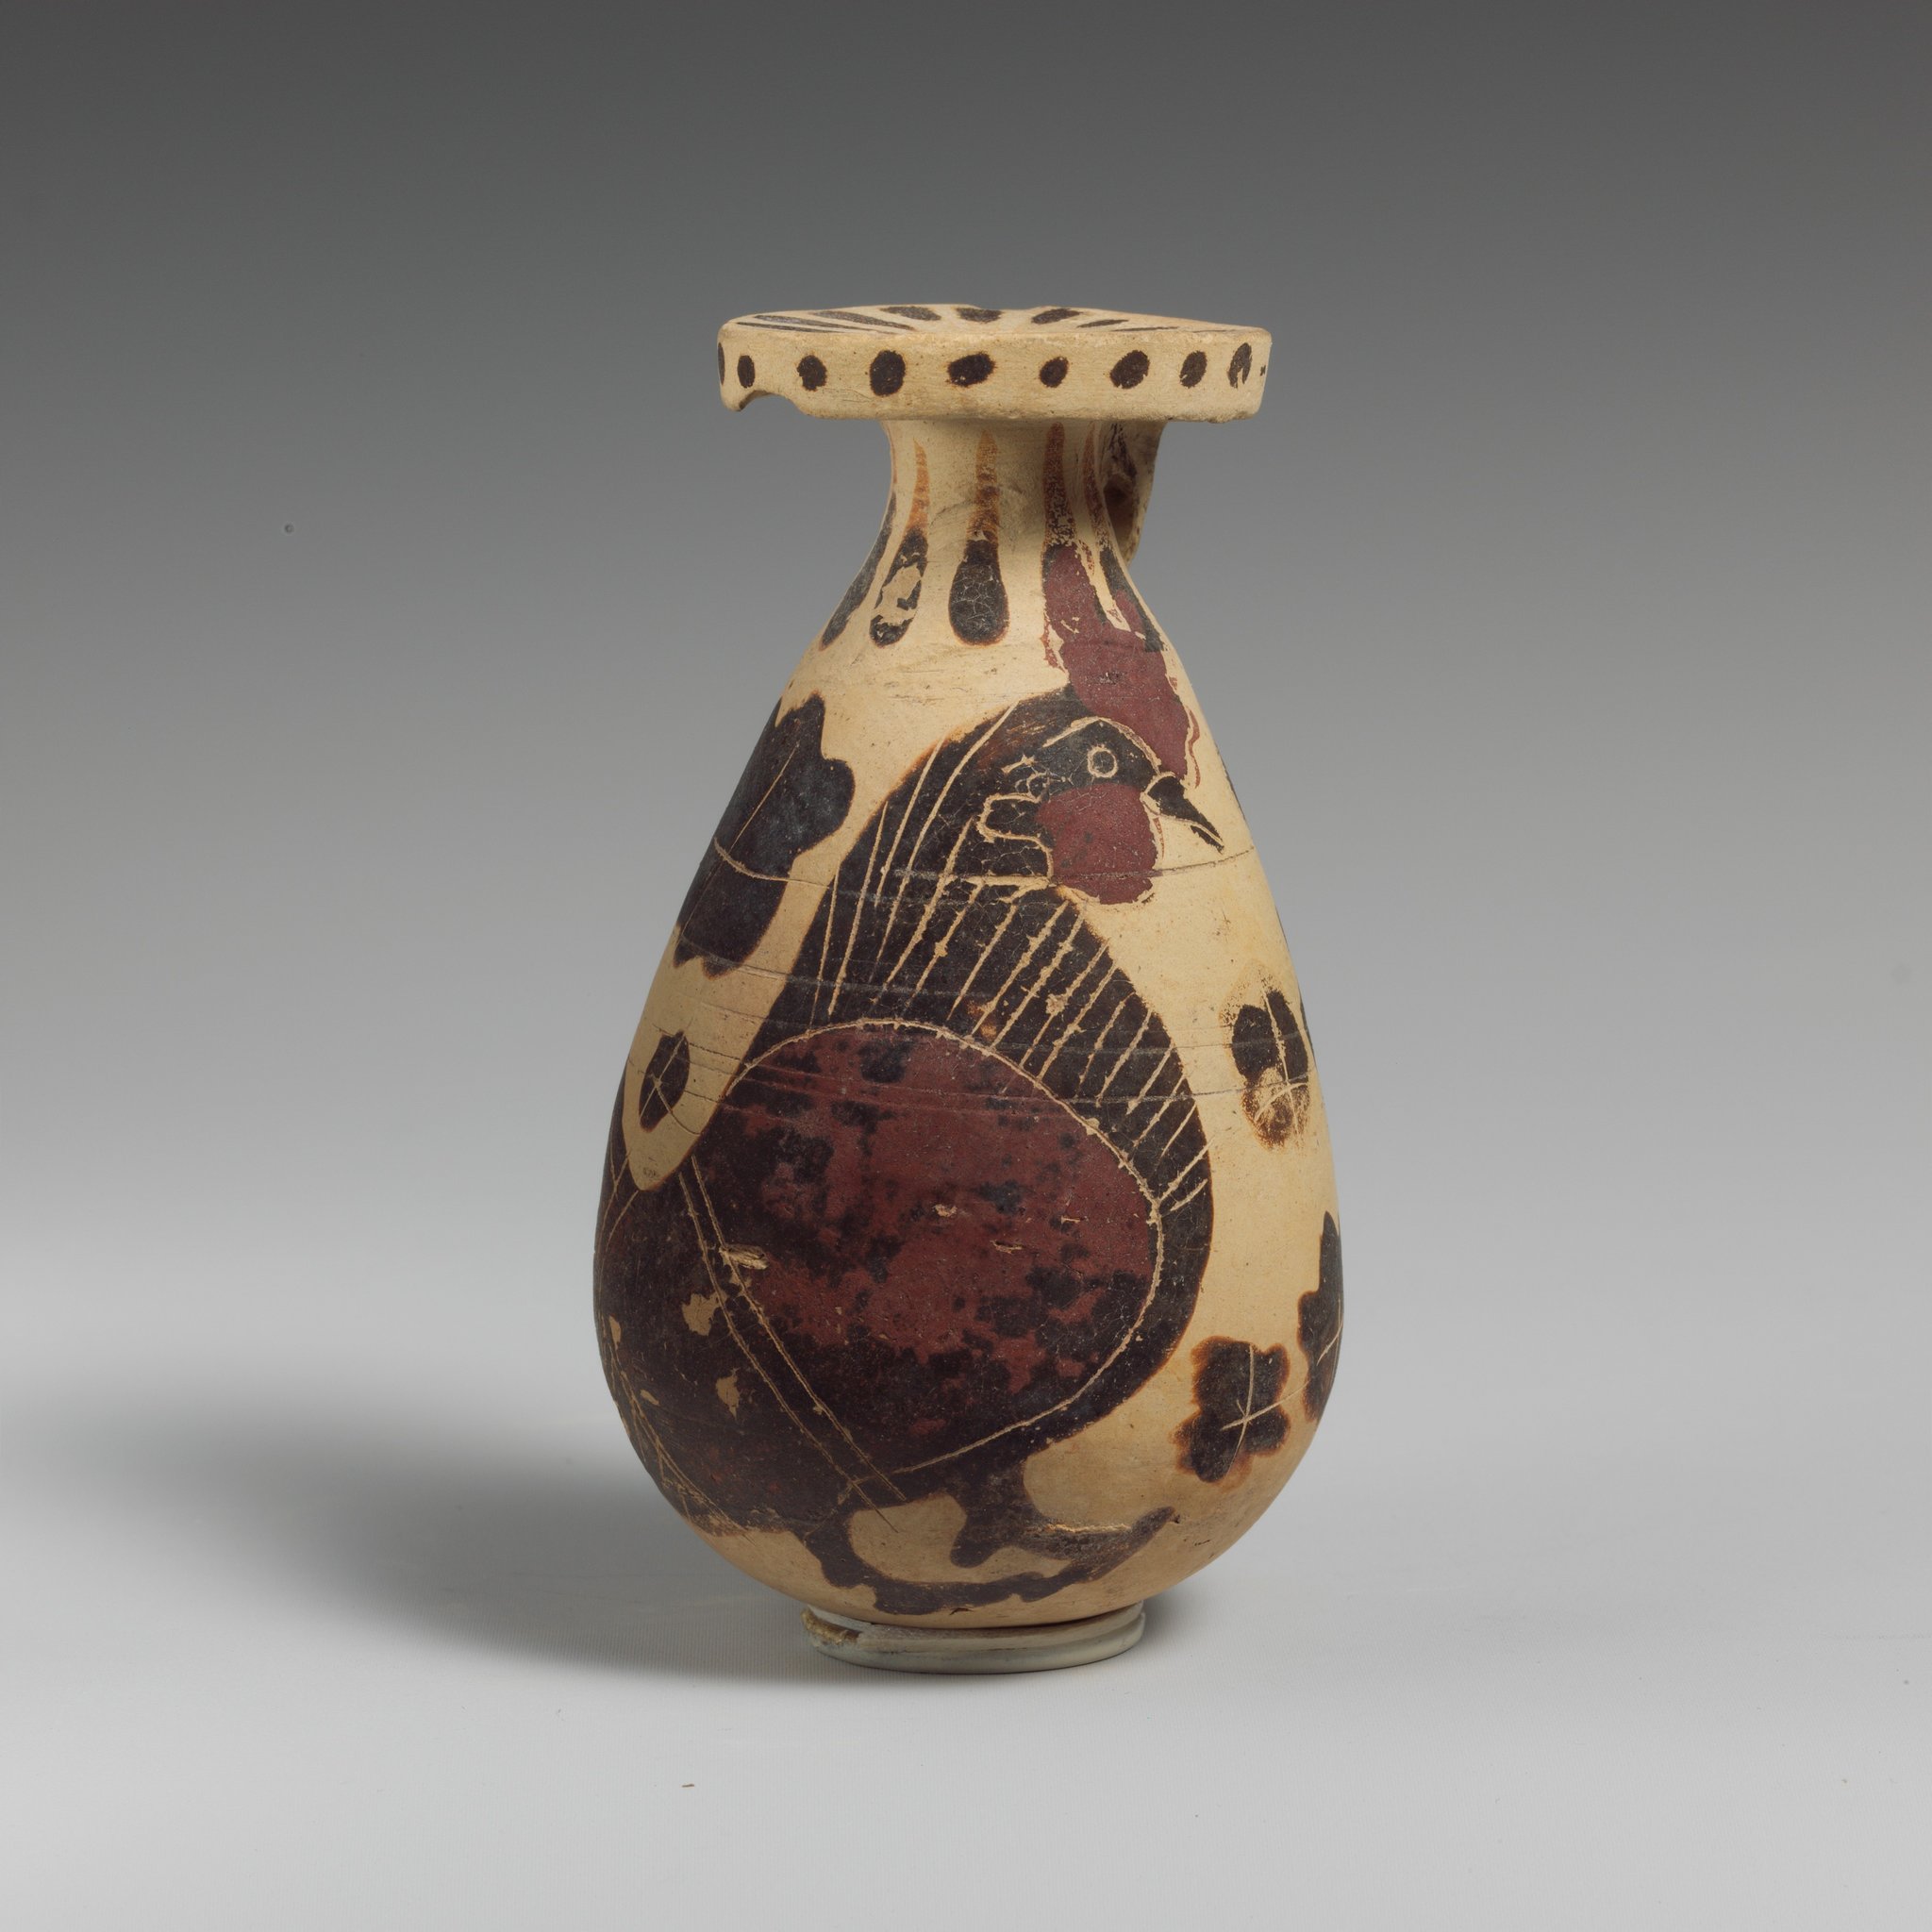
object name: alabastron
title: Terracotta alabastron (perfume vase)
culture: greek, corinthian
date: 620-590 BCE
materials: terracotta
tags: roosters